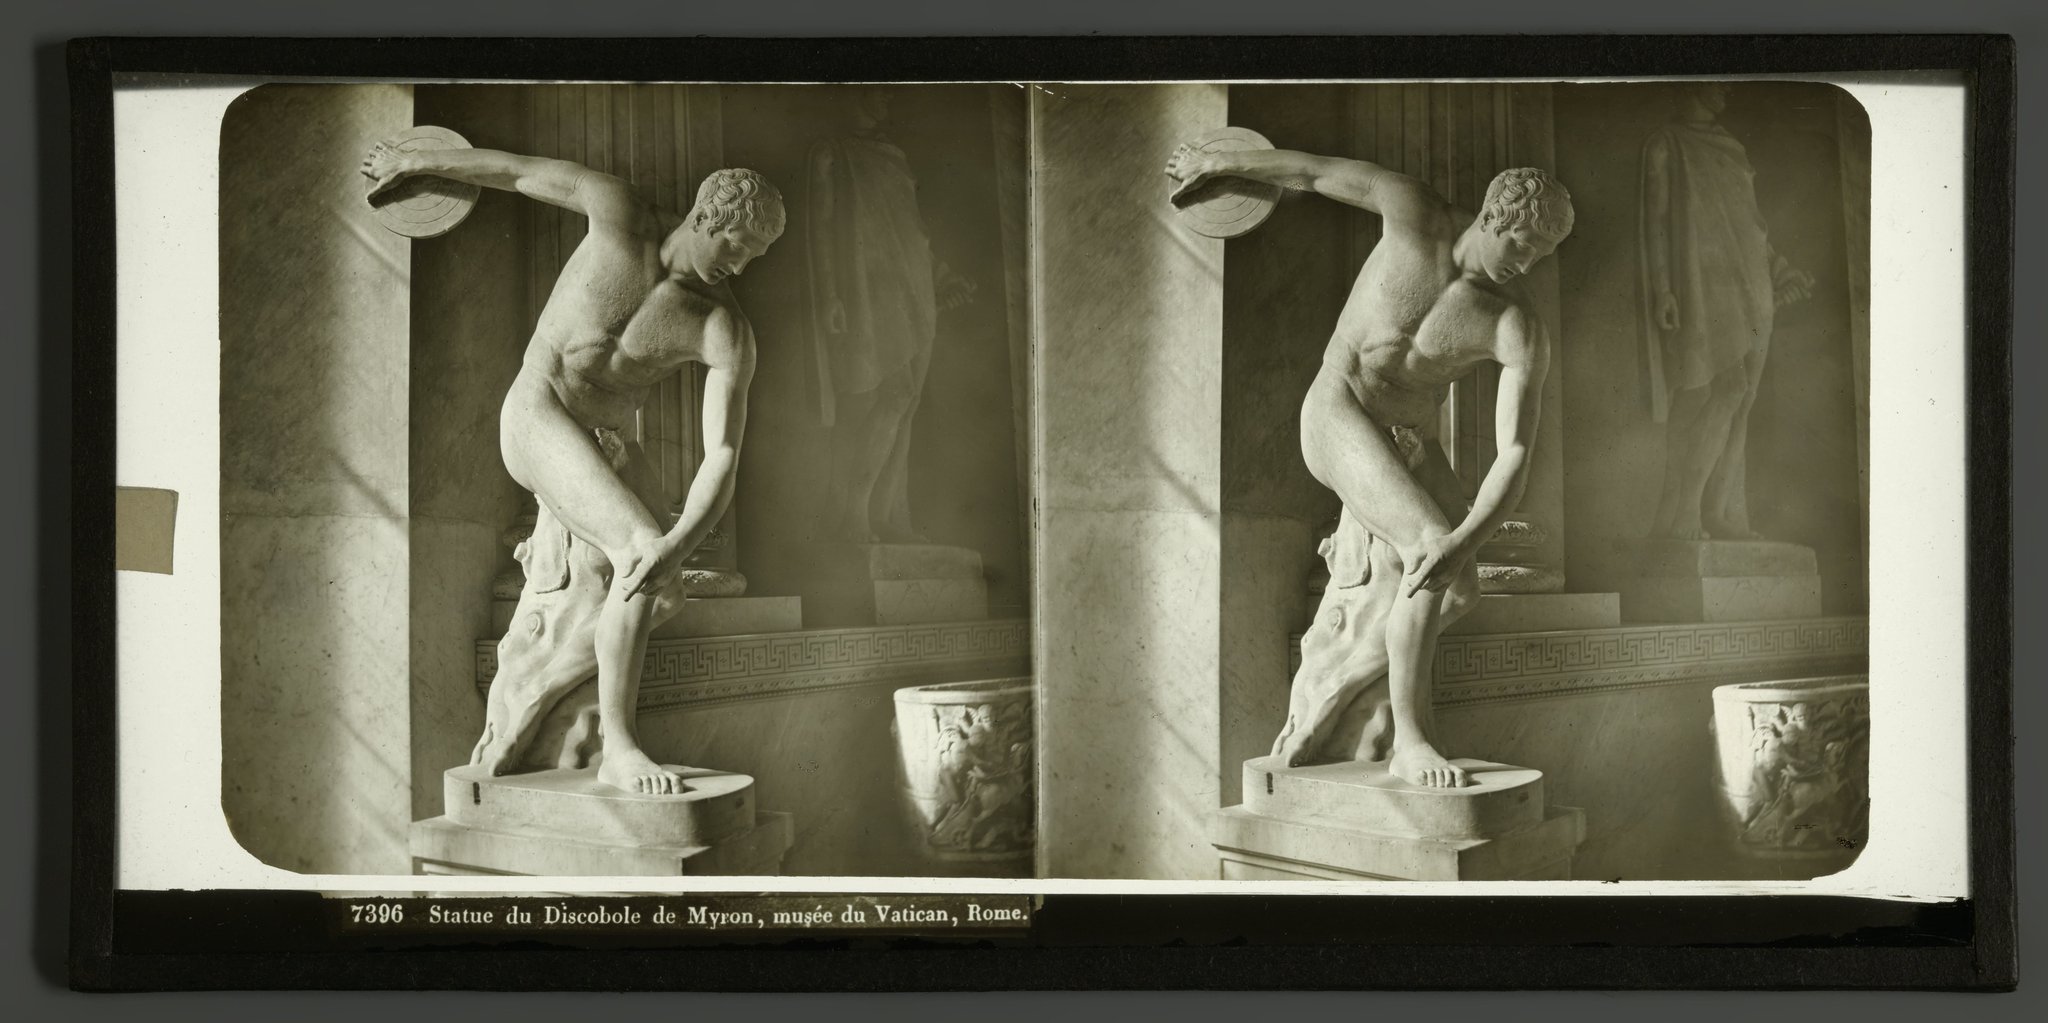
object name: stereoscopic photograph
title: Standbeeld van de discuswerper, Vaticaanstad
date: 1860-1870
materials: glass, paper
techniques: slide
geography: vatican city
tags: discus-throwing, sculpture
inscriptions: inscription: ‘7396 Statue du Discobole de Myron, musee du Vatican, Rome’